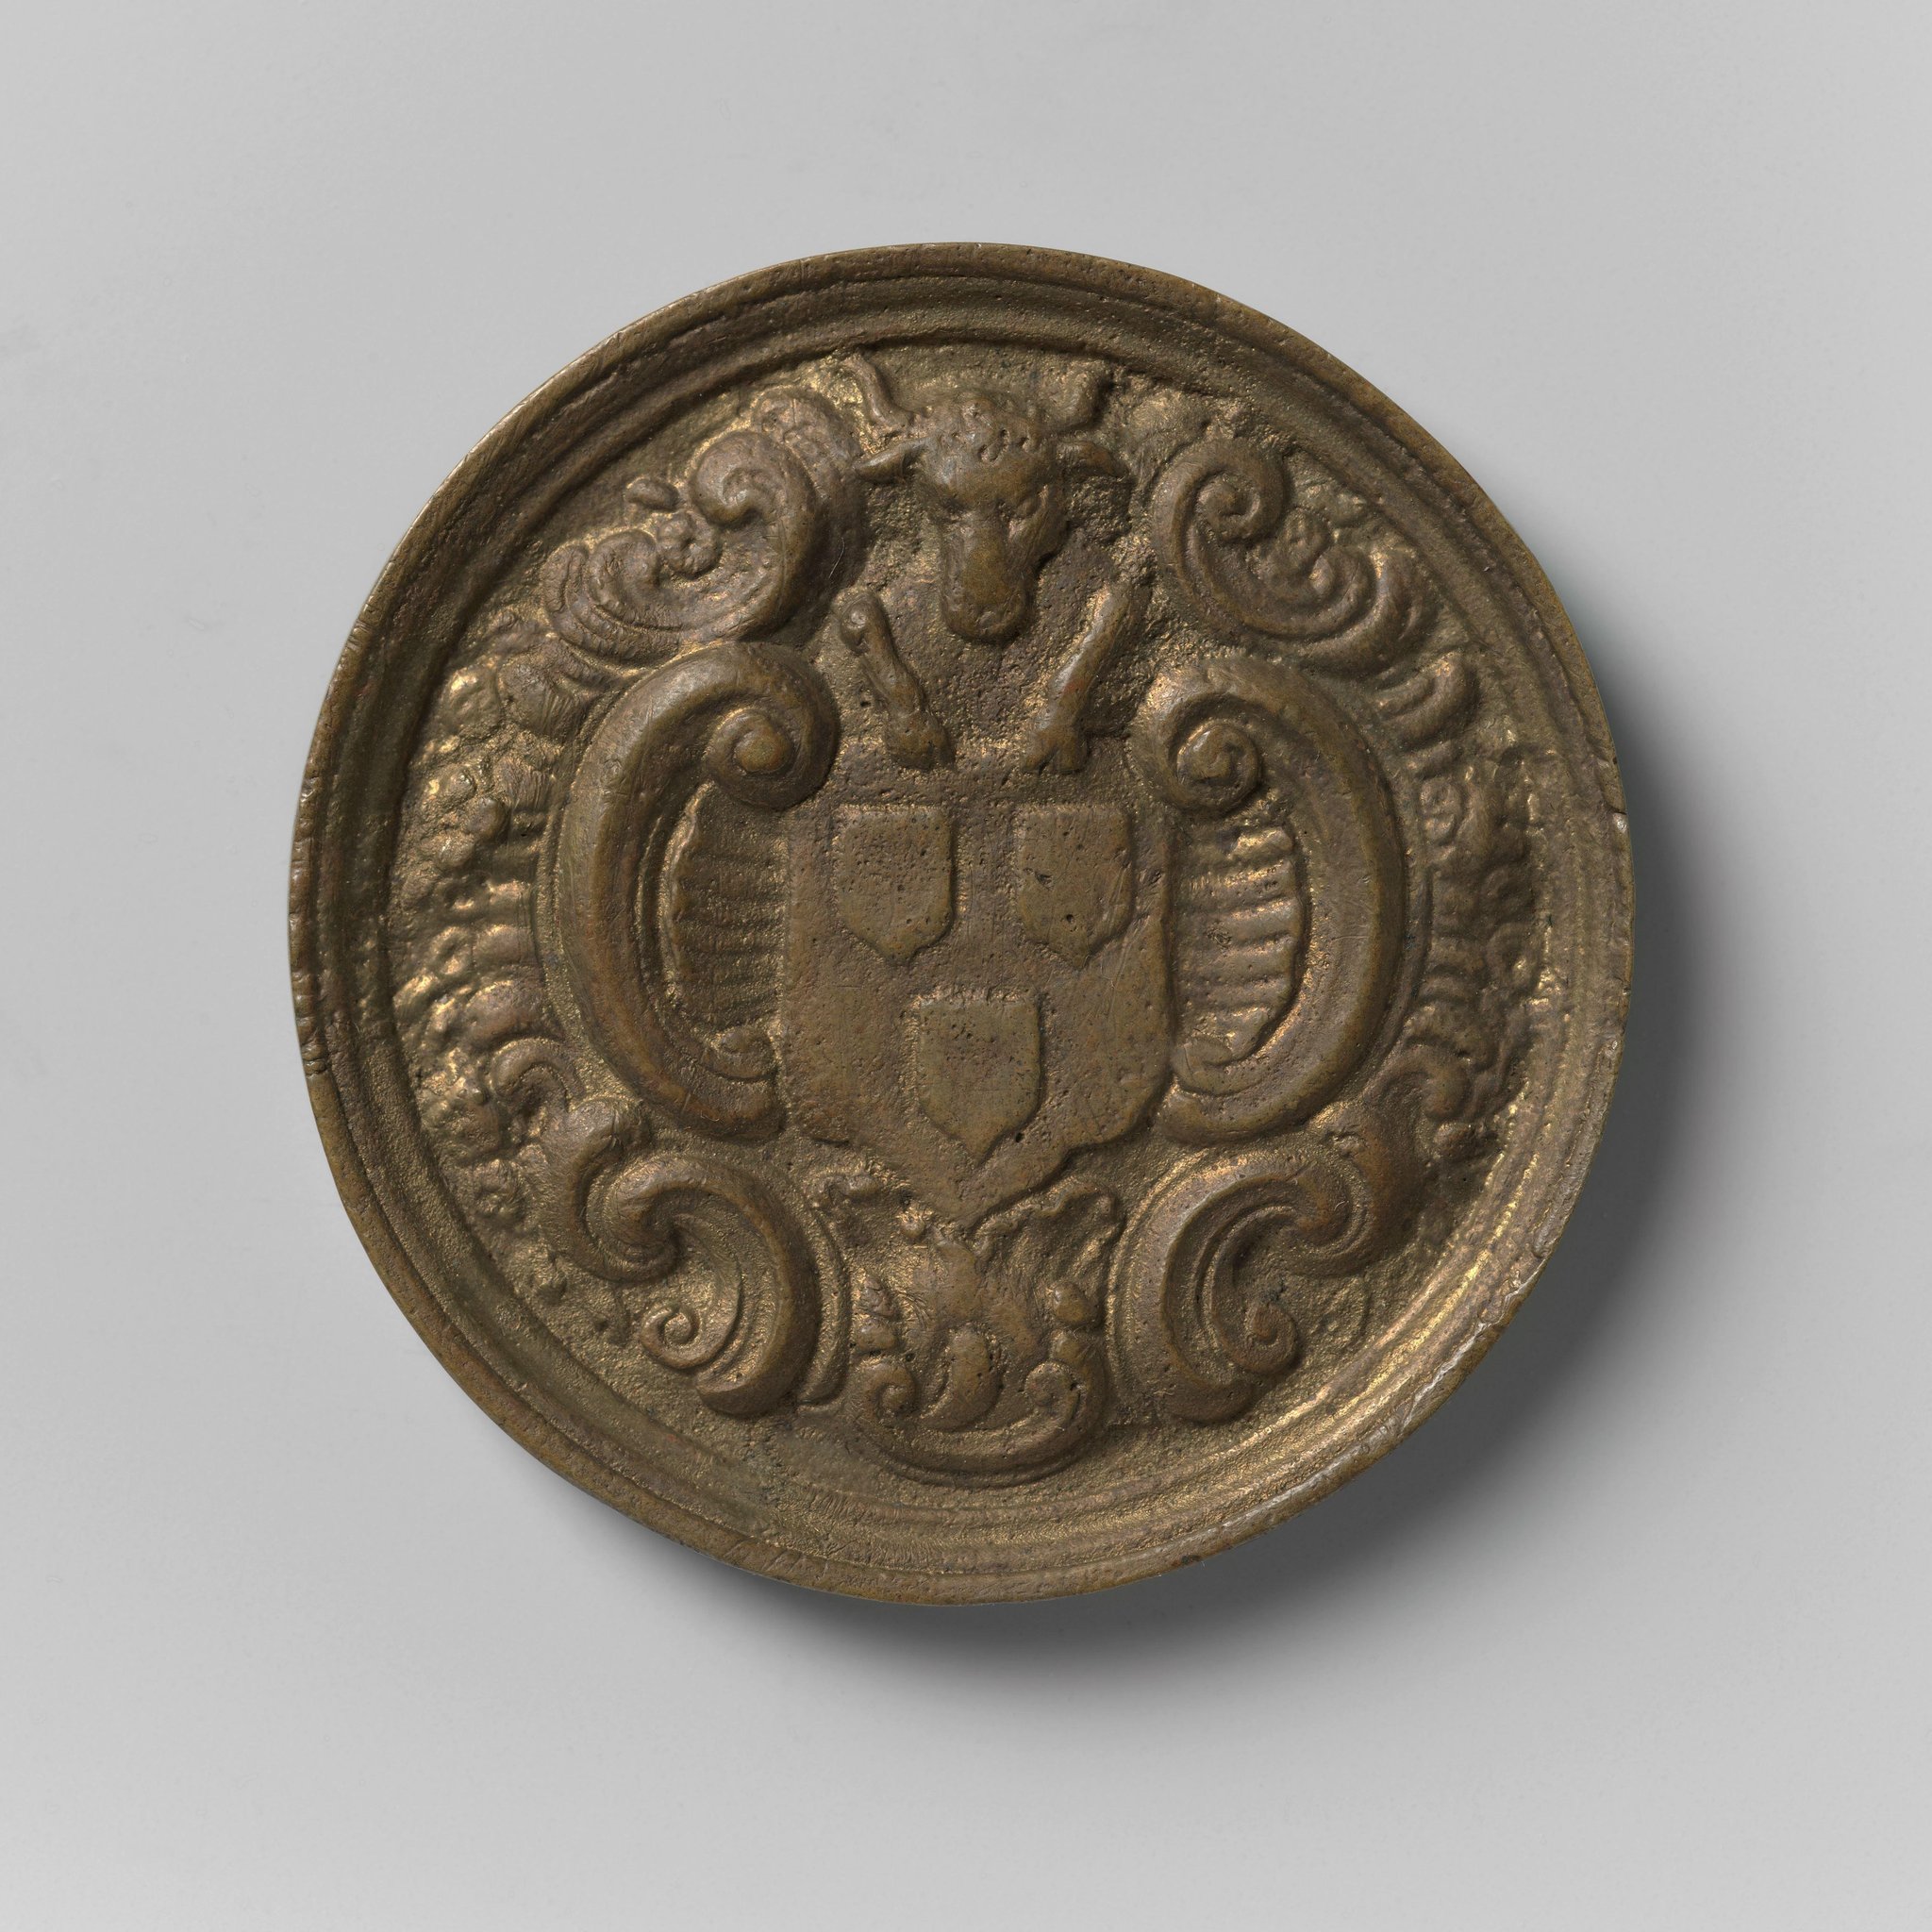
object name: history medal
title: Presentiepenning van het Sint Lucas- of Schildersgilde te Amsterdam, 1751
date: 1751-1788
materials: brass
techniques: casting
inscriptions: inscription: ‘1788 // LEENDERT / MULDER. // S’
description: Gegoten messing penning, op de voorzijde een Lucasschild gedragen door een os binnen een versierde cartouche, op de keerzijde een cartouche versierd met doodshoofd, onder en boven inscriptieruimtes, op naam van Leendert Mulder S 1788